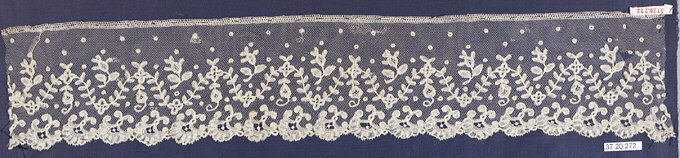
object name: border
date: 1801-1900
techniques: lace